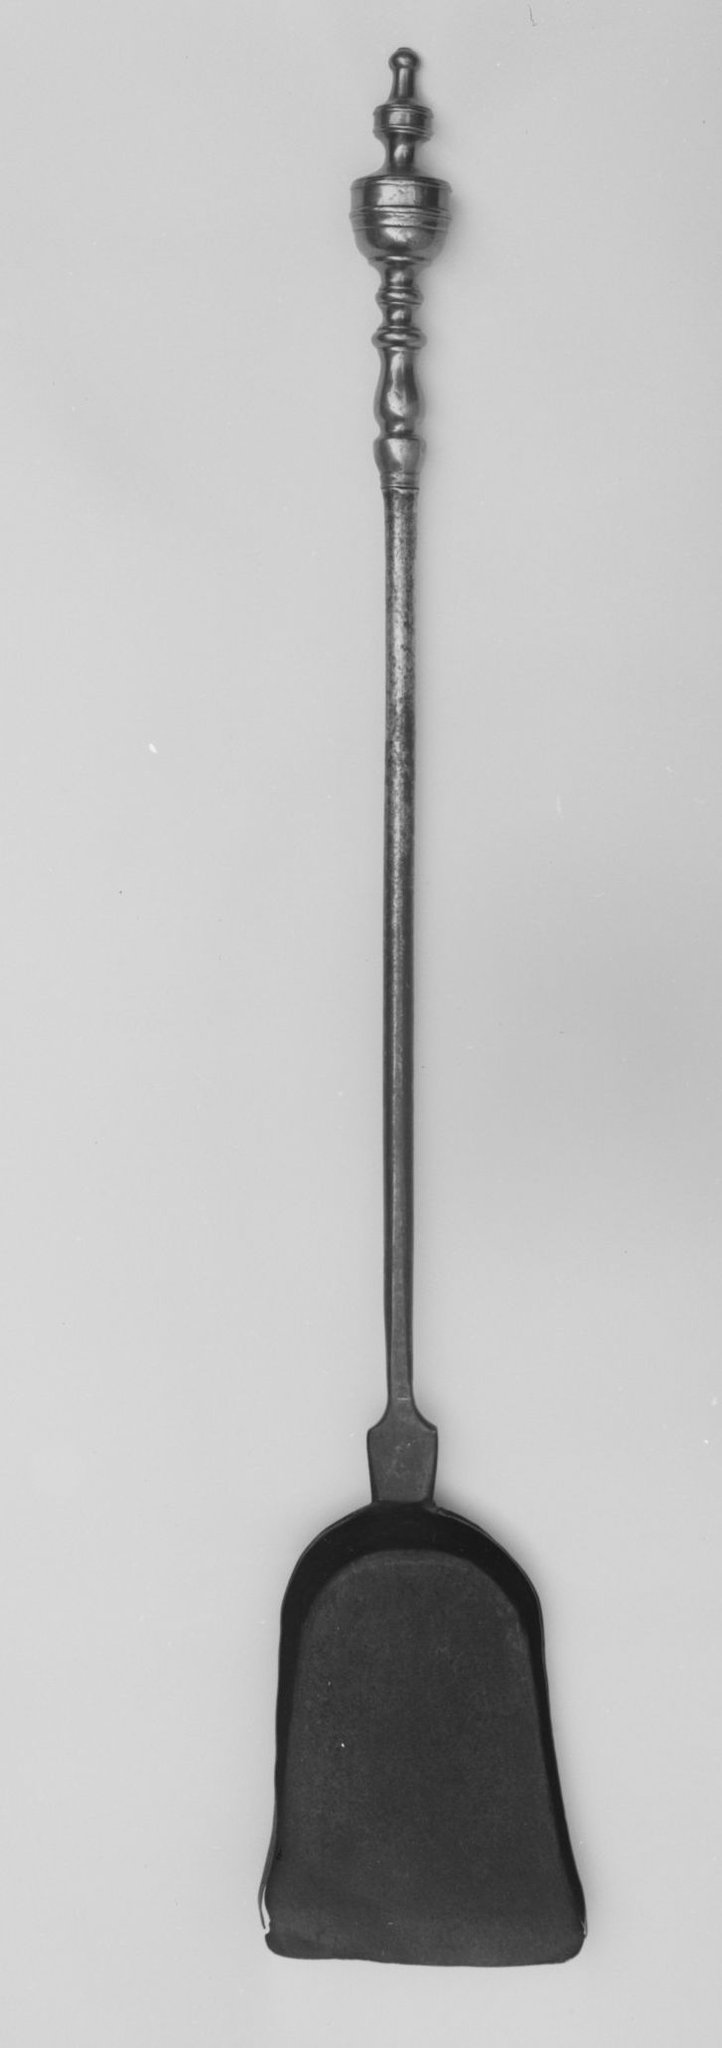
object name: fire shovel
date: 1770-1800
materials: brass, iron